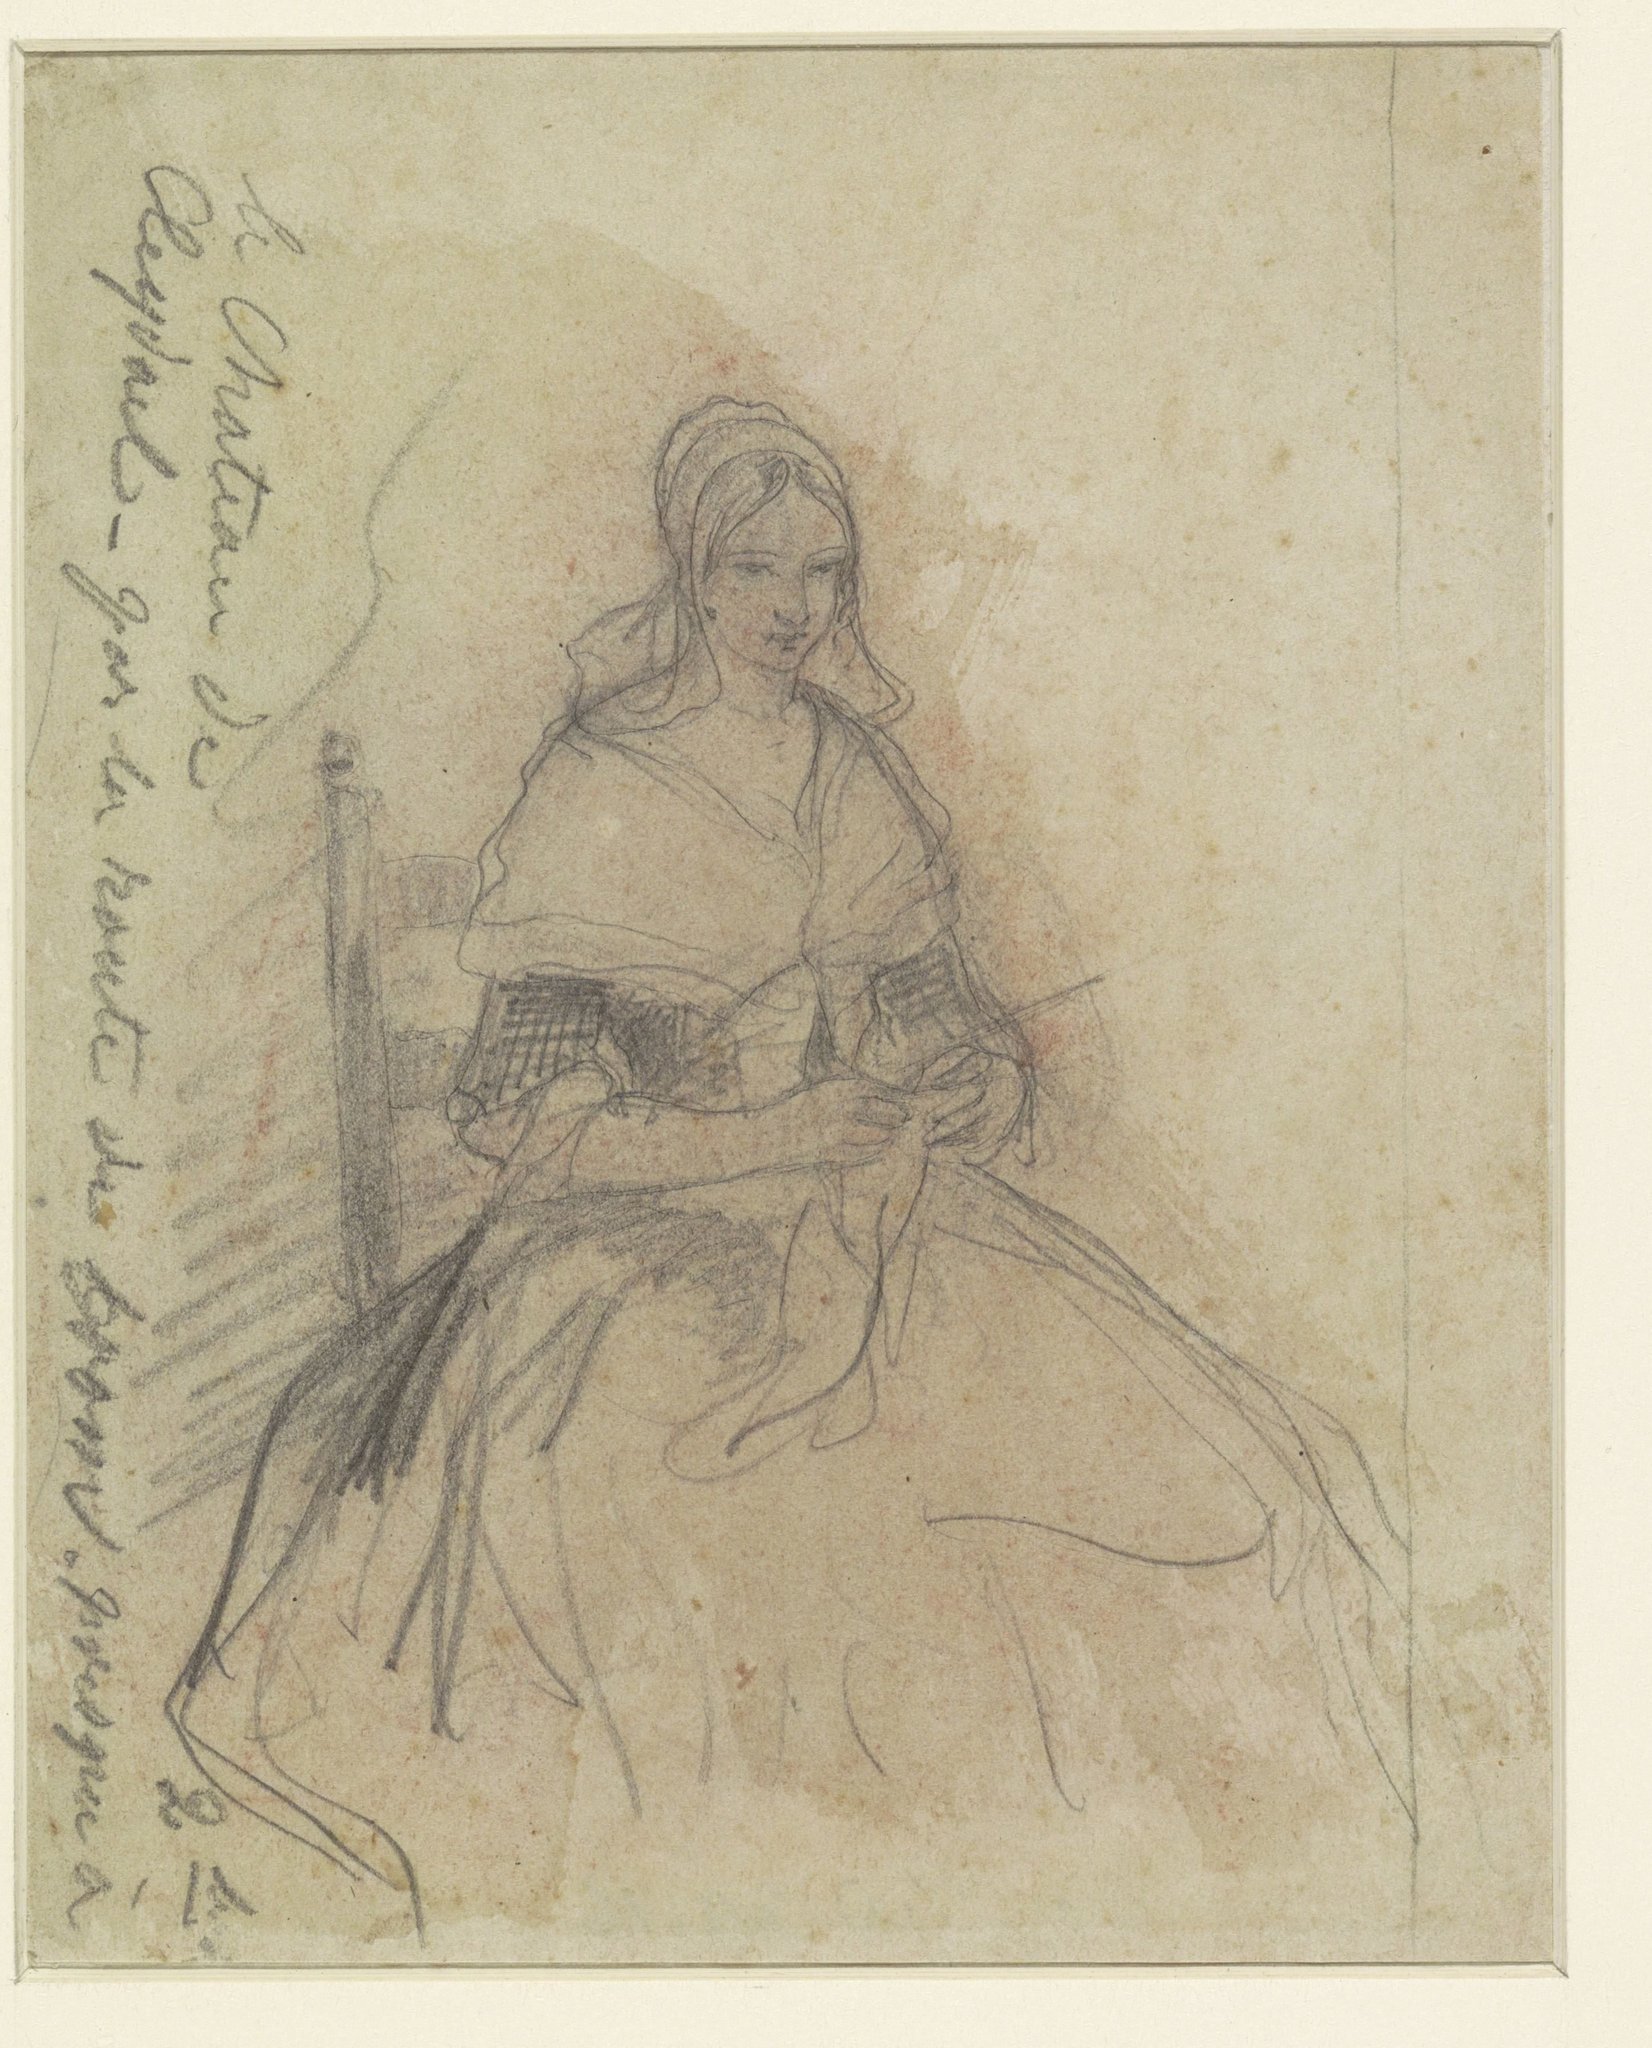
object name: design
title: Zittende breiende vrouw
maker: eugène françois de block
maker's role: draughtsman, painter, print maker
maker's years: 1812-1893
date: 1822-1893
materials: chalk, paper, pencil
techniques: pouncing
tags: (other forms of) needlework, e.g.: crocheting, knitting, embroidering